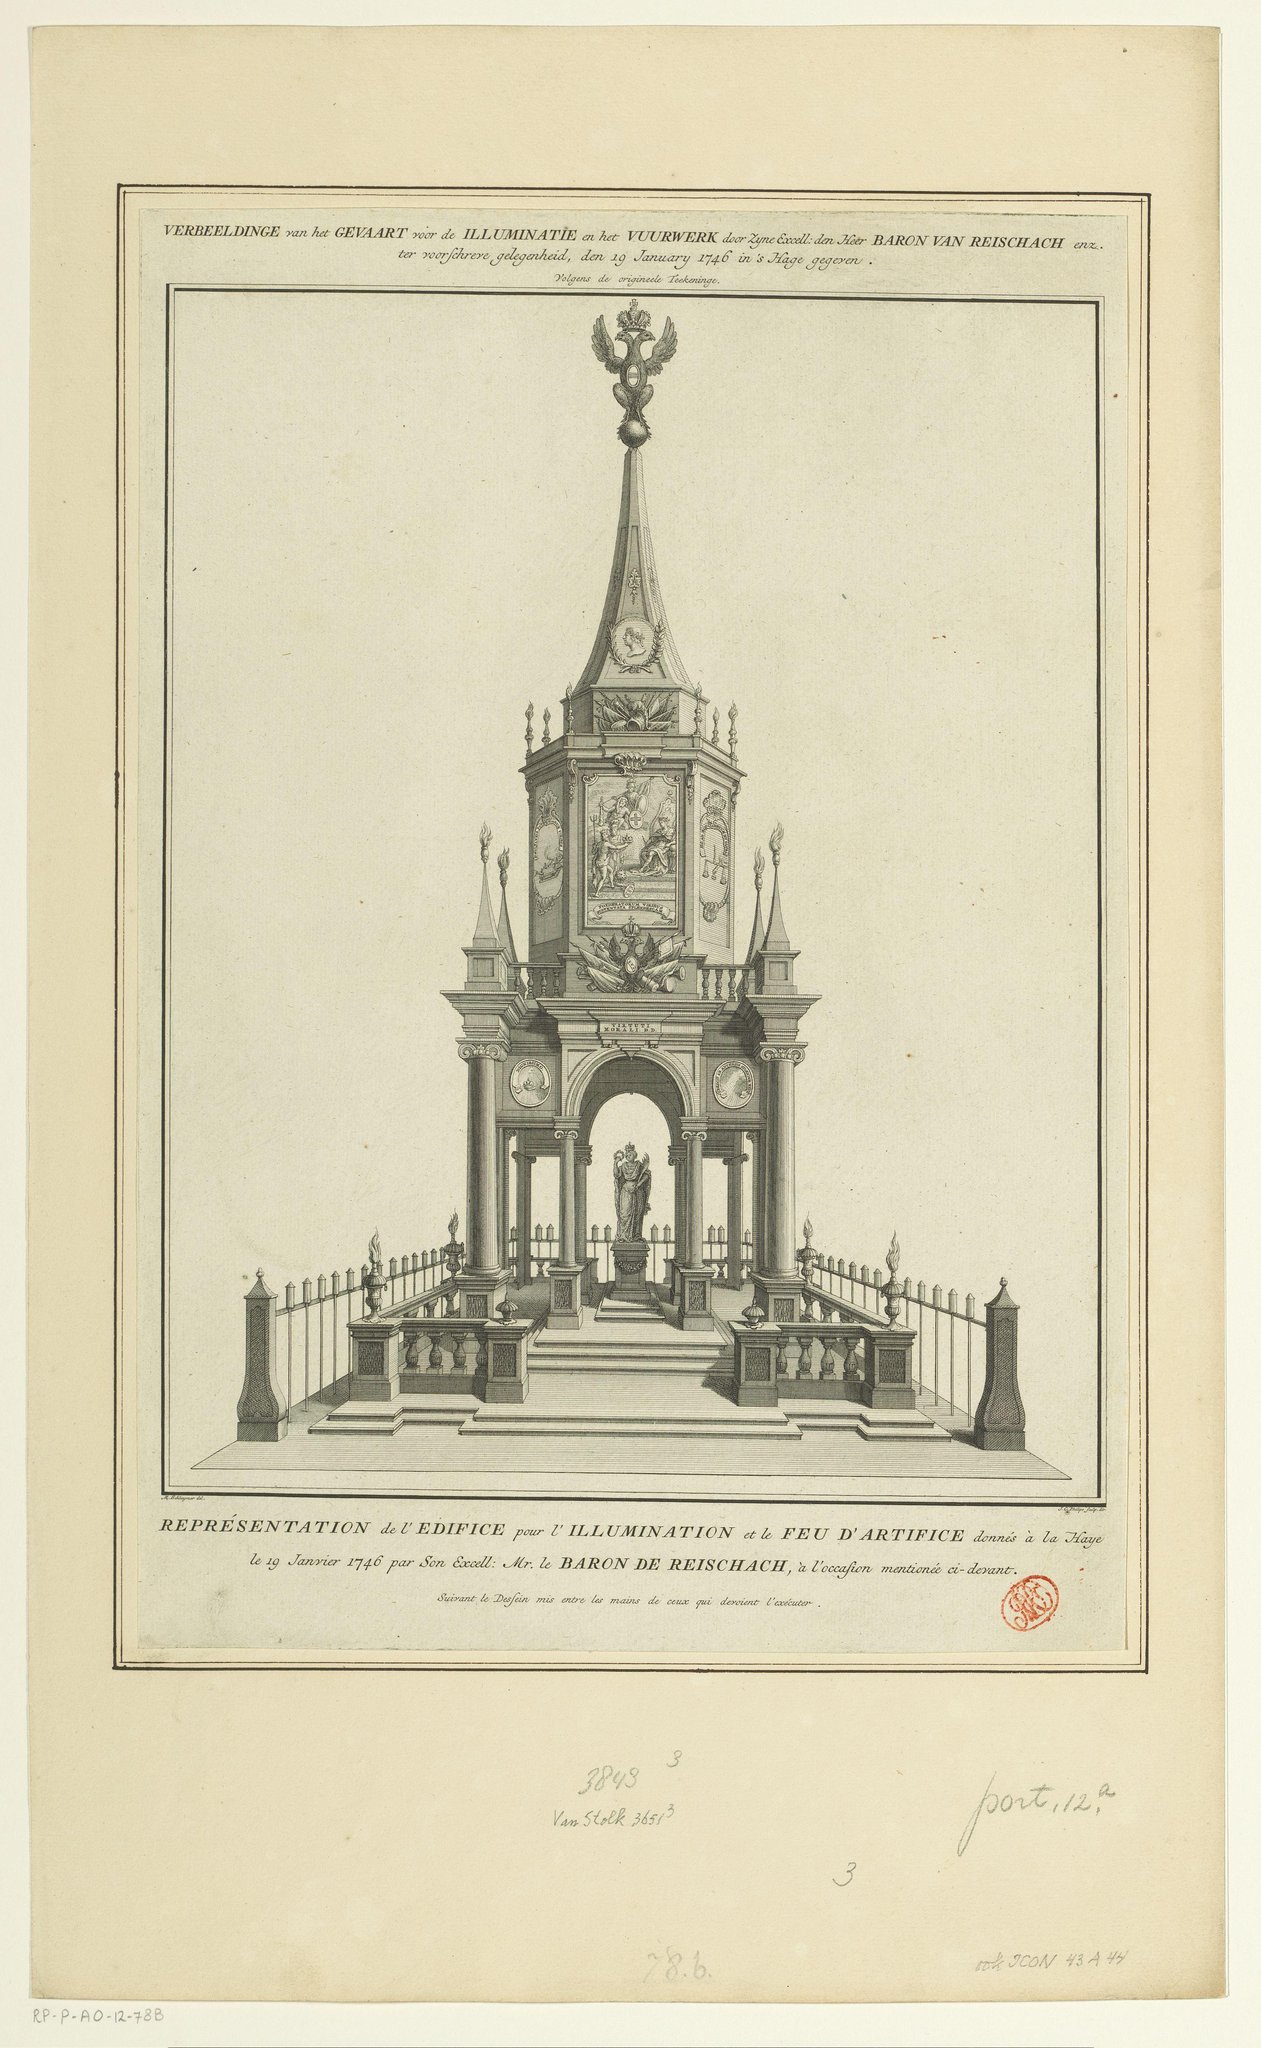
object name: print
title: Description des principales rejouissances, faites à la Haye, a l'occasion du couronnnement de (...) François I / Beschryving der voornaamste vreugde-bedryven in 's Gravenhage ter gelegenheid van de krooning van zyne keizerlyke majesteit Franciscus I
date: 1746-1747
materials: paper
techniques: engraving, etching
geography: northern netherlands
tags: frans i stefan (duits keizer), public festivities (+ illumination, fire-works ~ festive activities), coronation of a ruler, bonfire, fire-works (+ illumination, fire-works ~ festive activities)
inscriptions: collector's mark: Lugt 195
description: Het bouwwerk (tempel of gevaarte) voor het vuurwerk afgestoken op 19 januari 1746 op de Hofvijver te Den Haag in opdracht van de Duitse minister en afgezant baron van Reischach ter gelegenheid van de kroning van Frans I Stefan tot keizer op 4-6 oktober 1745.